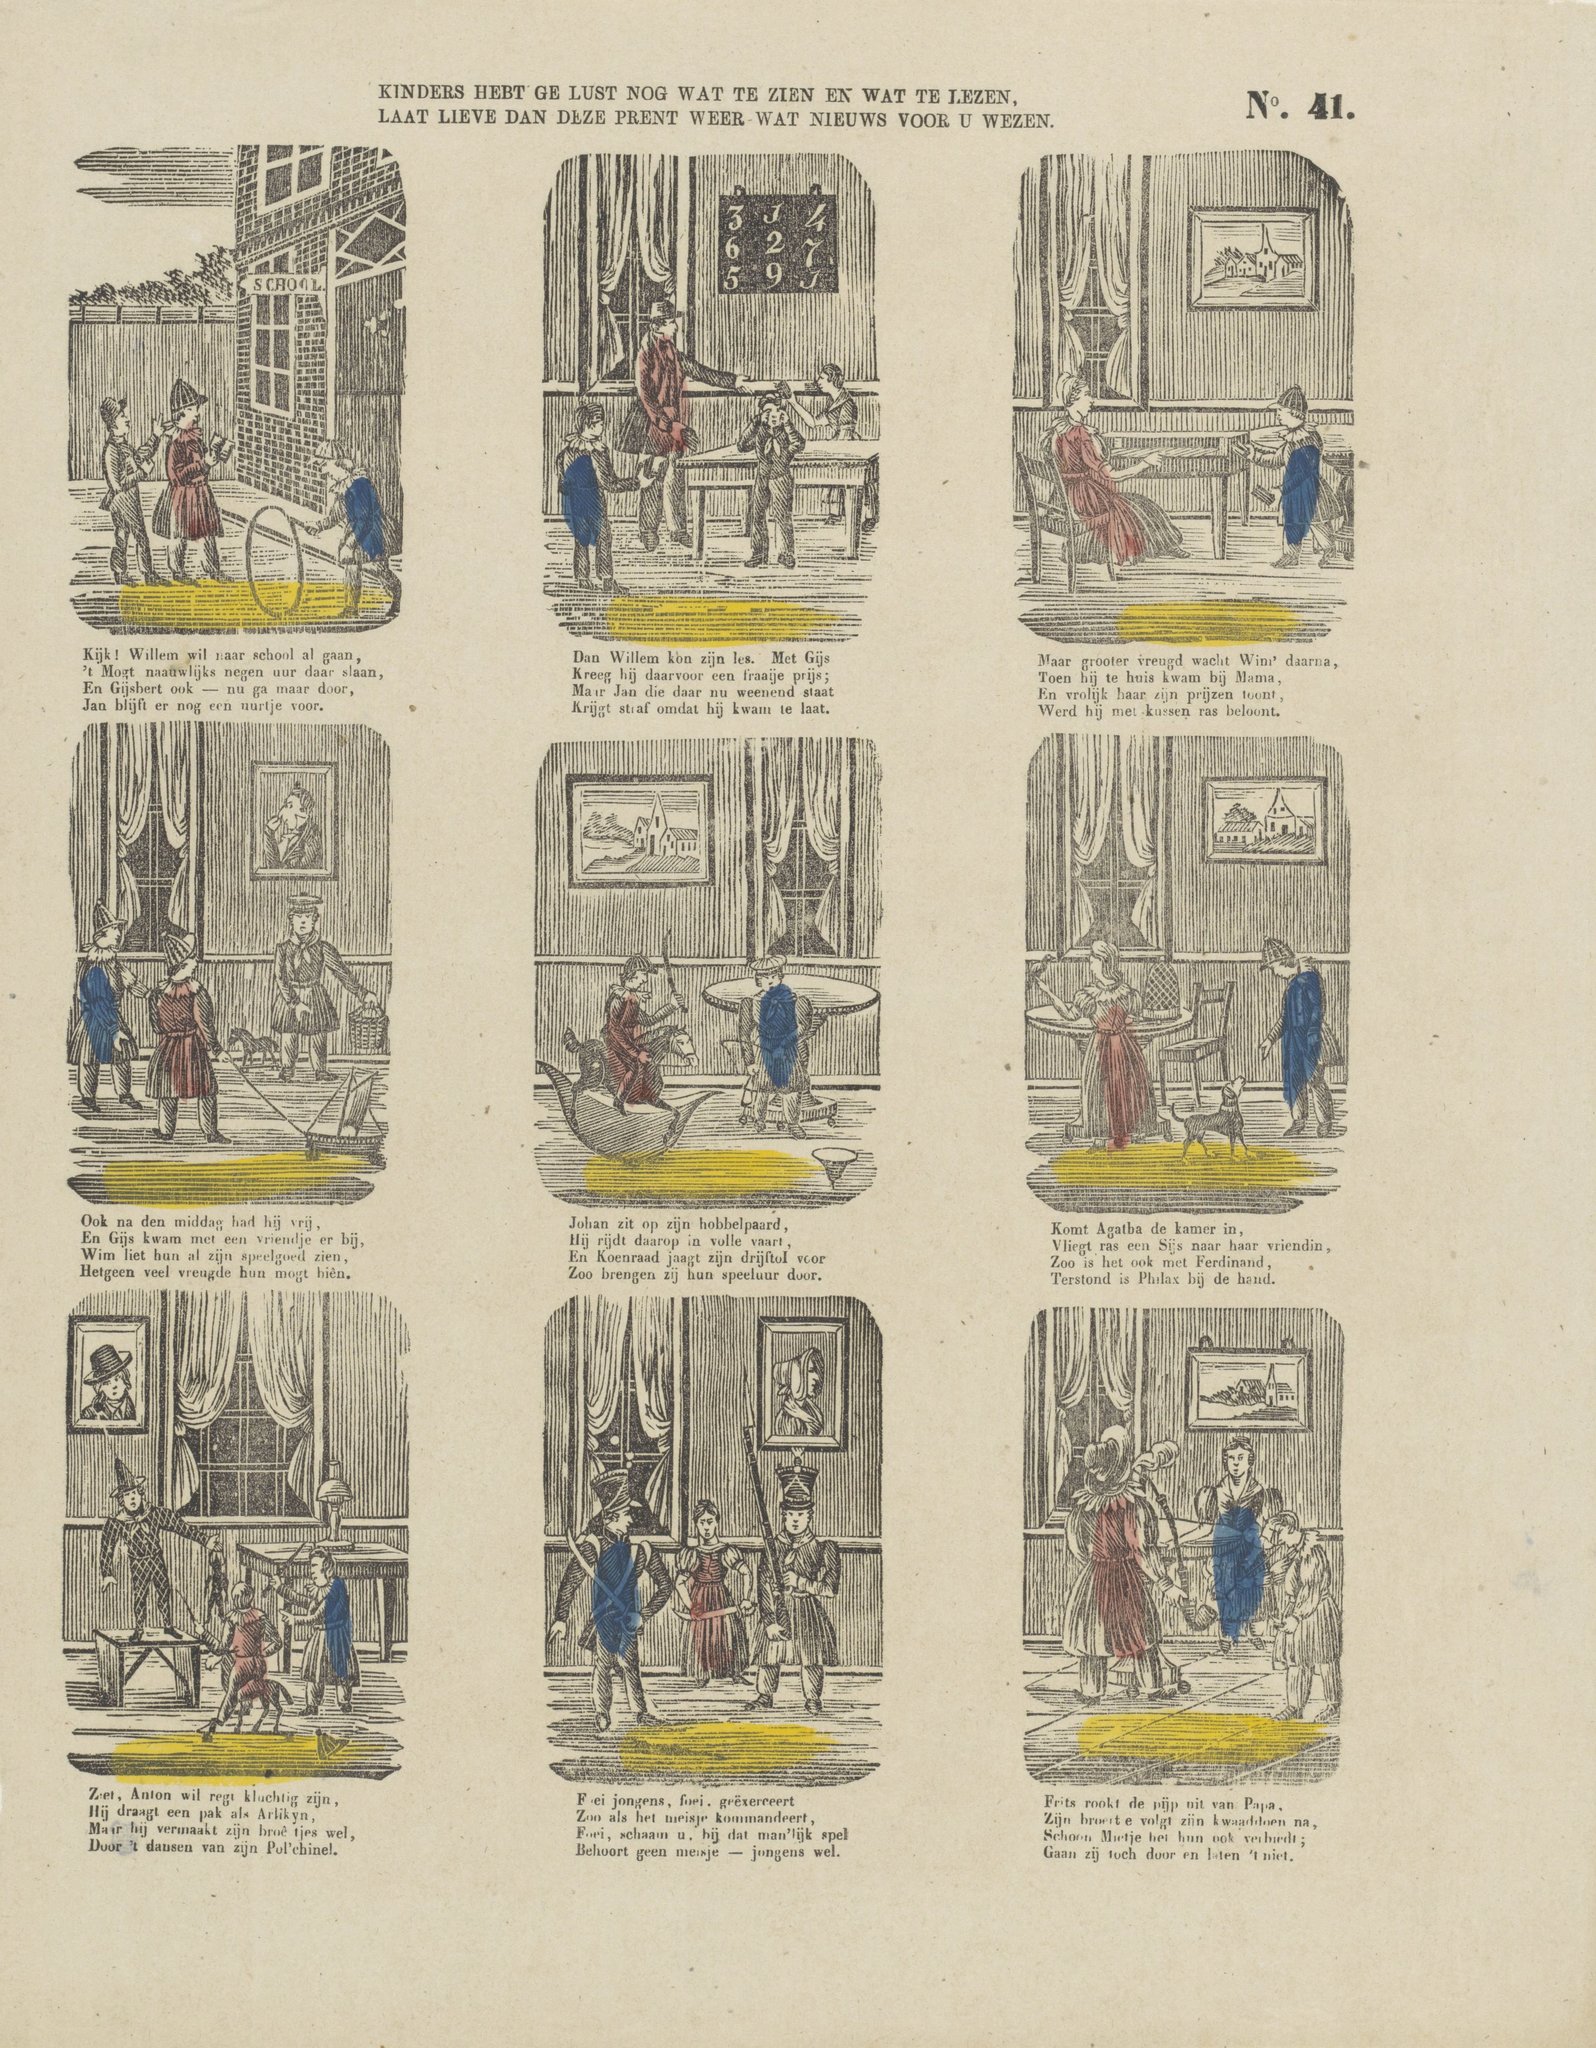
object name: popular print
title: Kinders hebt ge lust nog wat te zien en wat te lezen, / Laat lieve dan deze prent weer wat nieuws voor u wezen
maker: Anonymous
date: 1850-1870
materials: paper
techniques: colour, letterpress printing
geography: netherlands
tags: children's games and plays, games using special objects (marbles, top, hoop, etc.), rocking-horse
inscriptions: collector's mark: Lugt 2760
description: Blad met 9 voorstellingen van kinderspelen en bezigheden, zoals hoepelen, hobbelpaardje rijden en soldaatje spelen. Onder elke afbeelding een vierregelig vers. Rechtsboven genummerd: No. 41.